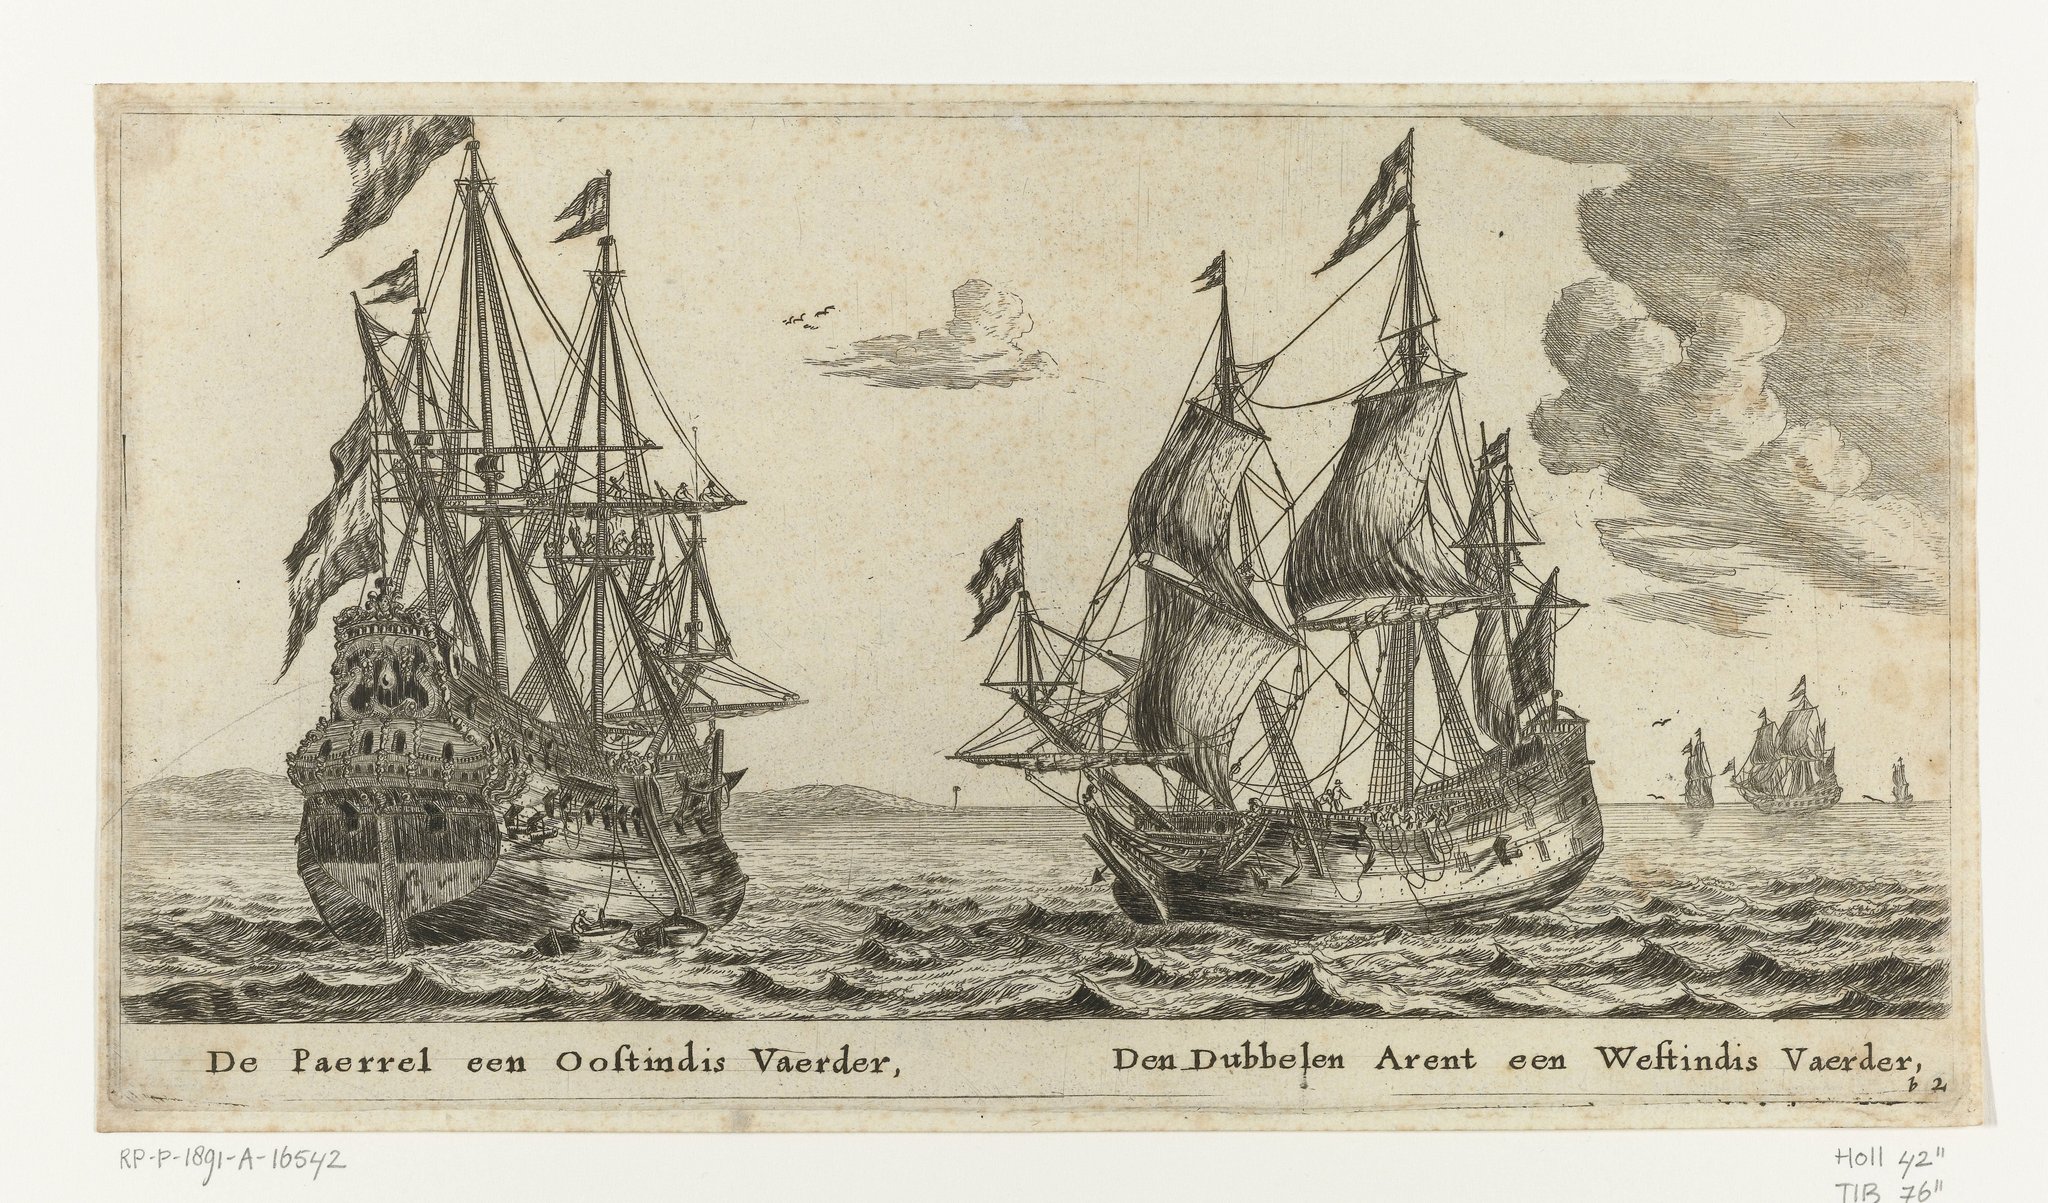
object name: print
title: Verschillende schepen en stadsgezichten van Amsterdam, tweede deel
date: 1652-1654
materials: paper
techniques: drypoint, etching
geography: netherlands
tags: ships (in general)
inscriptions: collector's mark: Lugt 2228, collector's mark: Lugt 1494, collector's mark: Lugt 462, collector's mark: Lugt 1227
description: Twee koopvaardijschepen op zee vlak bij land. Links De Parel, een Oost-indiëvaarder en rechts De Dubbele Arend, een West-indiëvaarder.